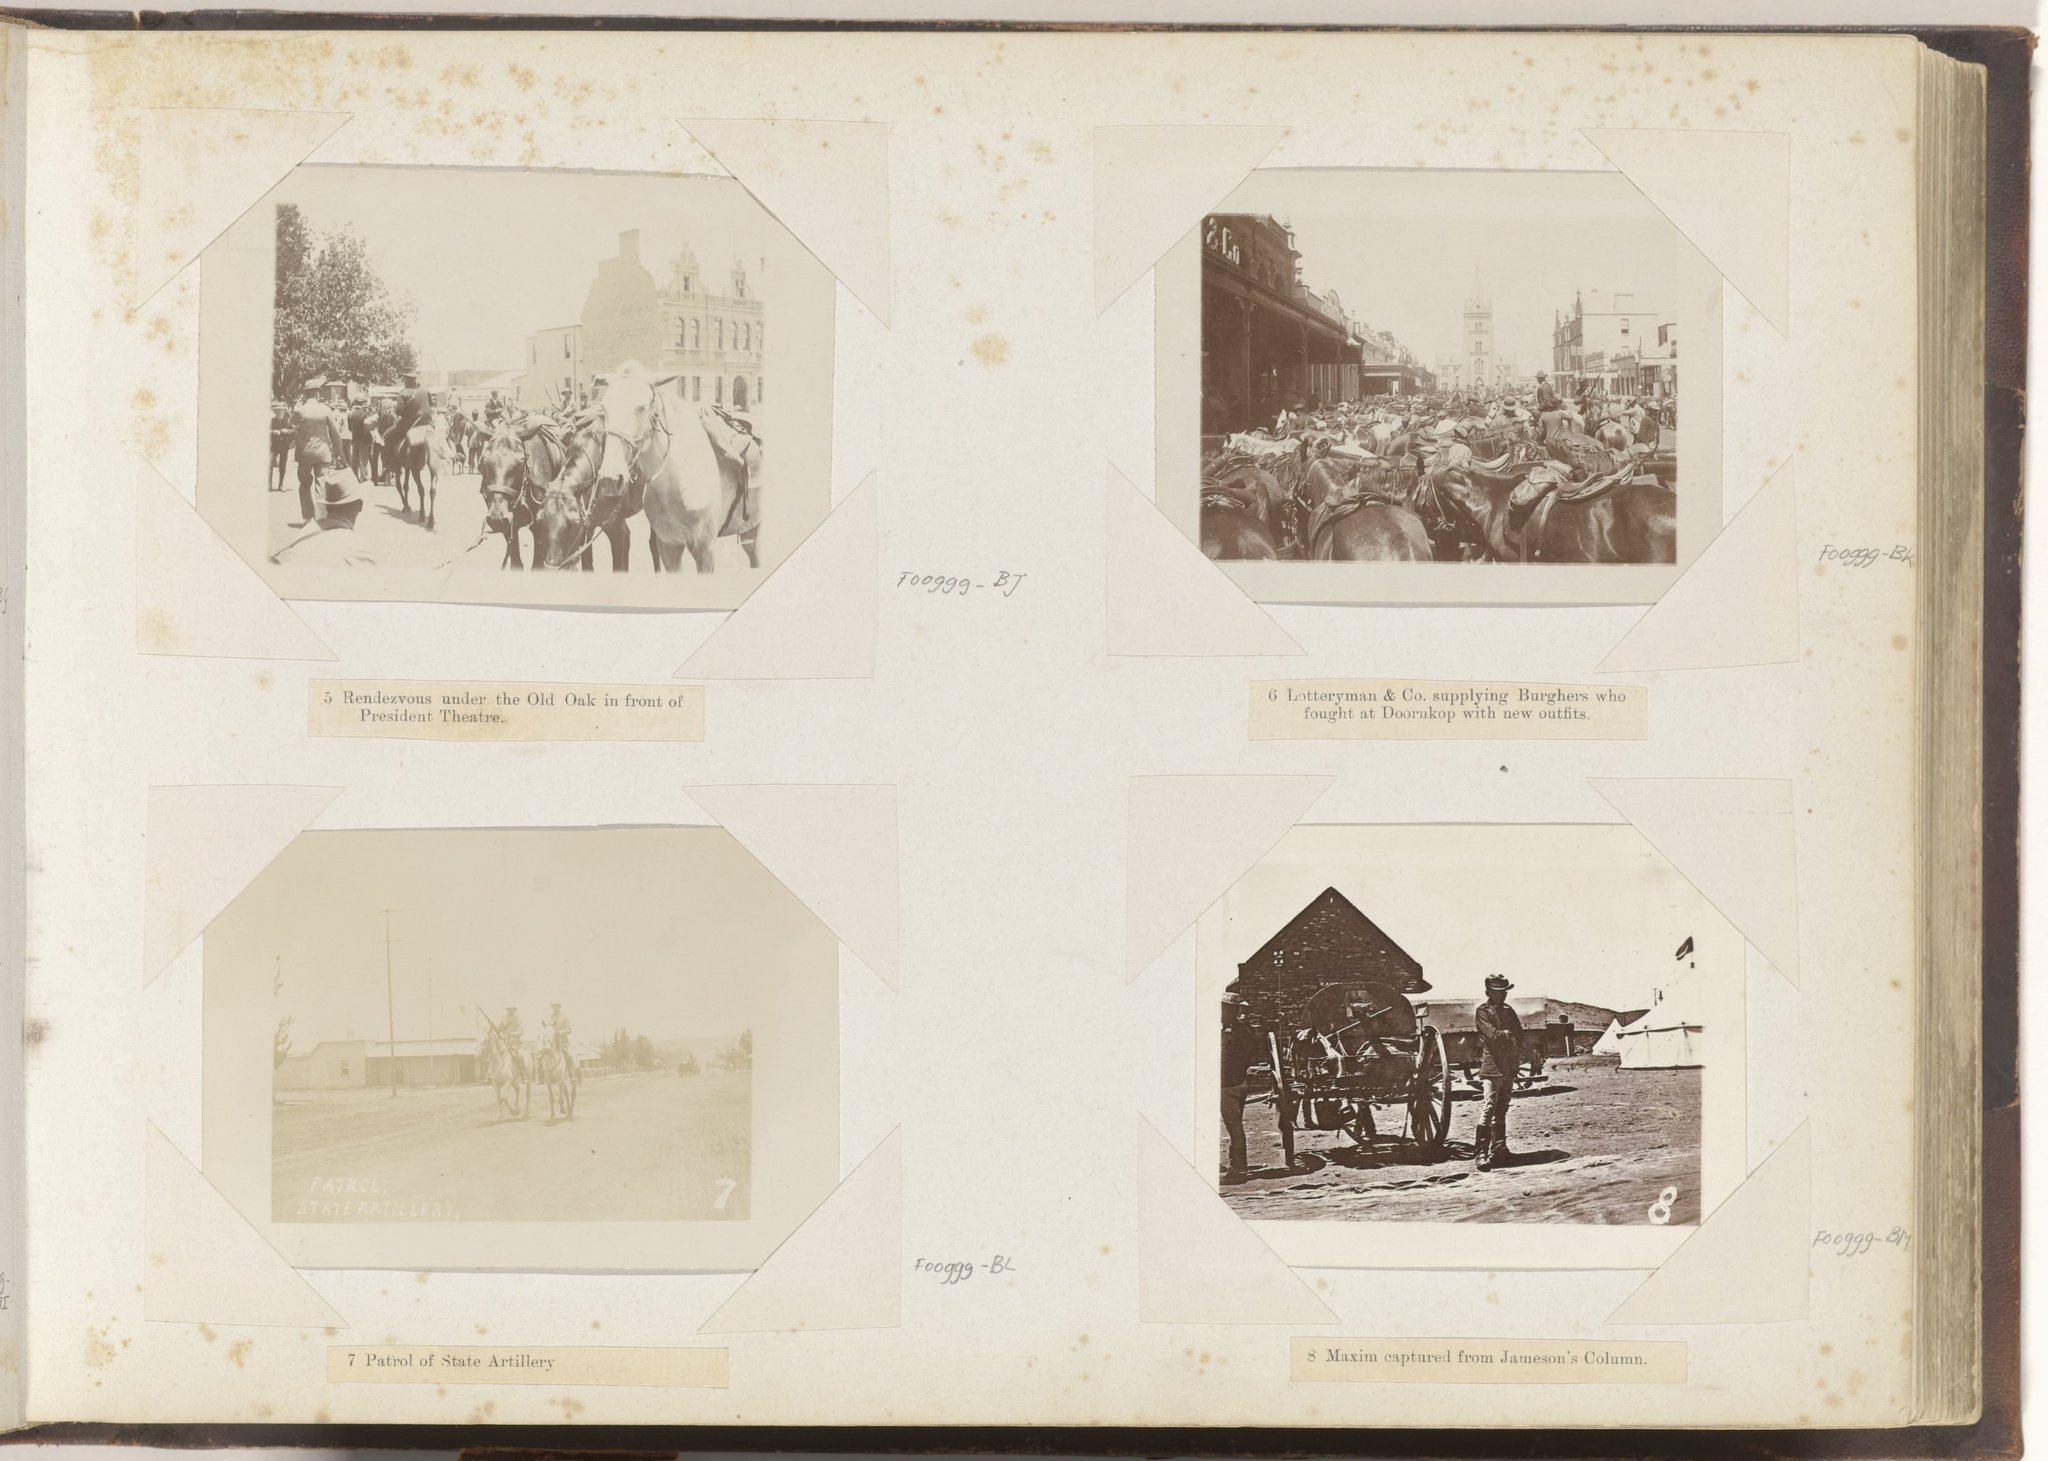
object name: photograph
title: Patrol of State Artillery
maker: Anonymous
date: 1896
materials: paper, photographic support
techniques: gelatin silver print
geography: south africa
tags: land forces (+ cavalry, horsemen)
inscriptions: inscription: ‘Patrol State Artillery 7’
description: Onderdeel van Album met 191 foto's van een reis naar en door Zuid-Afrika.